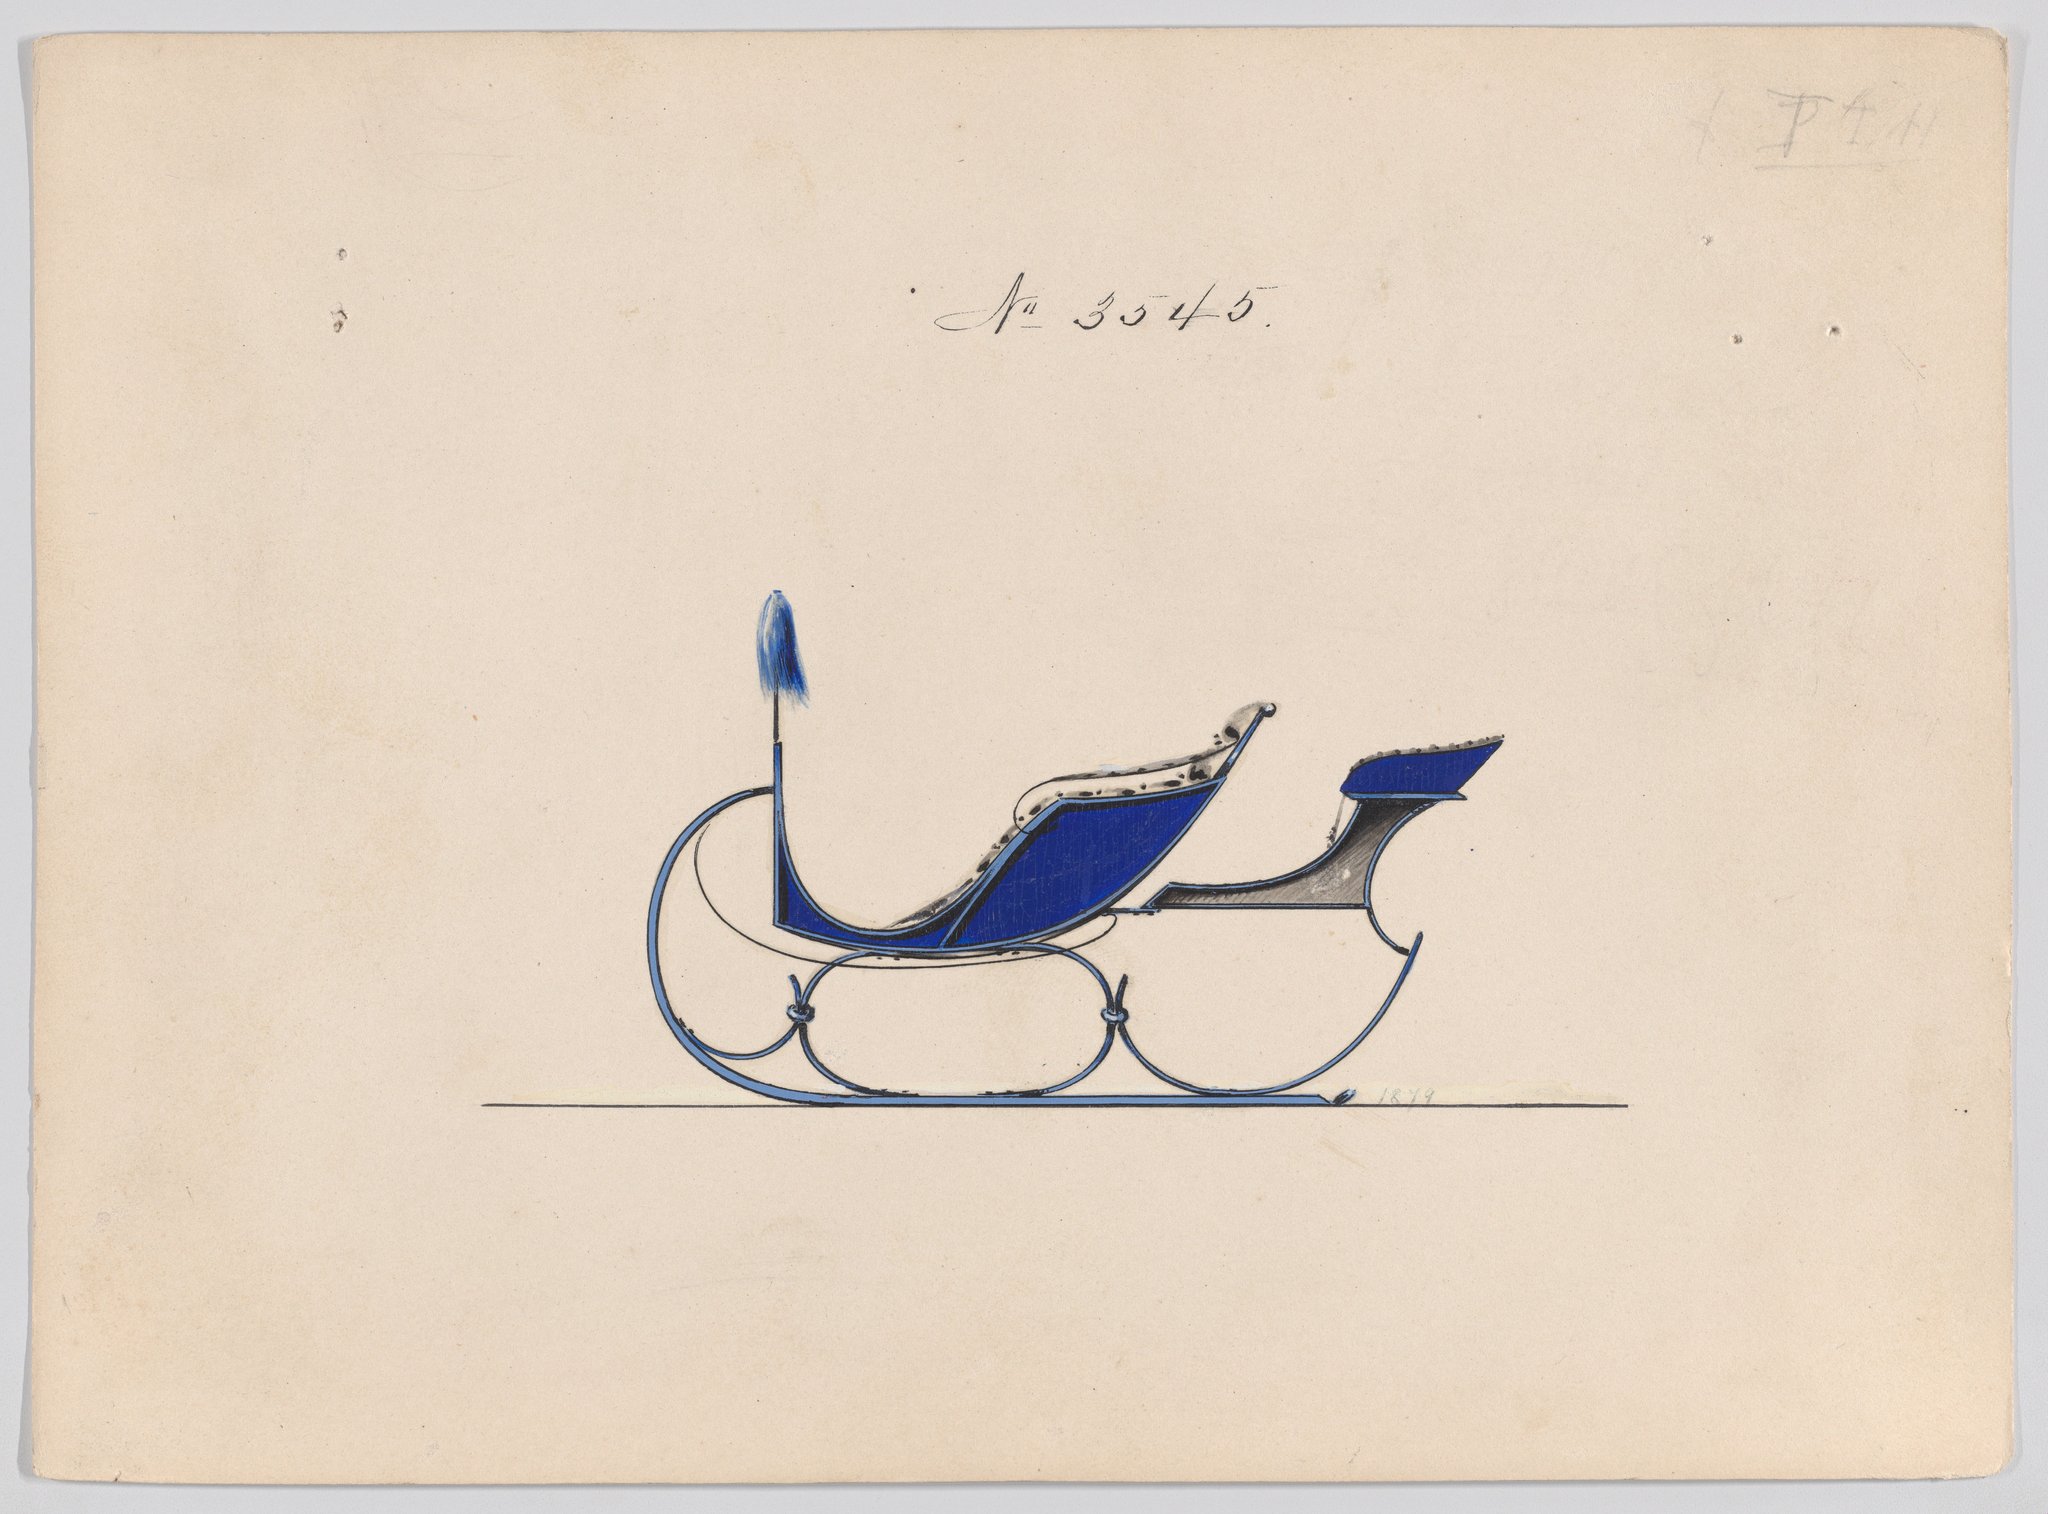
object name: drawing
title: Sleigh with Rumble Seat # 3545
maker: brewster & co.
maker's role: manufacturer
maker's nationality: american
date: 1879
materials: gouache, gum arabic, ink, watercolor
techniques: pen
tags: sleighs